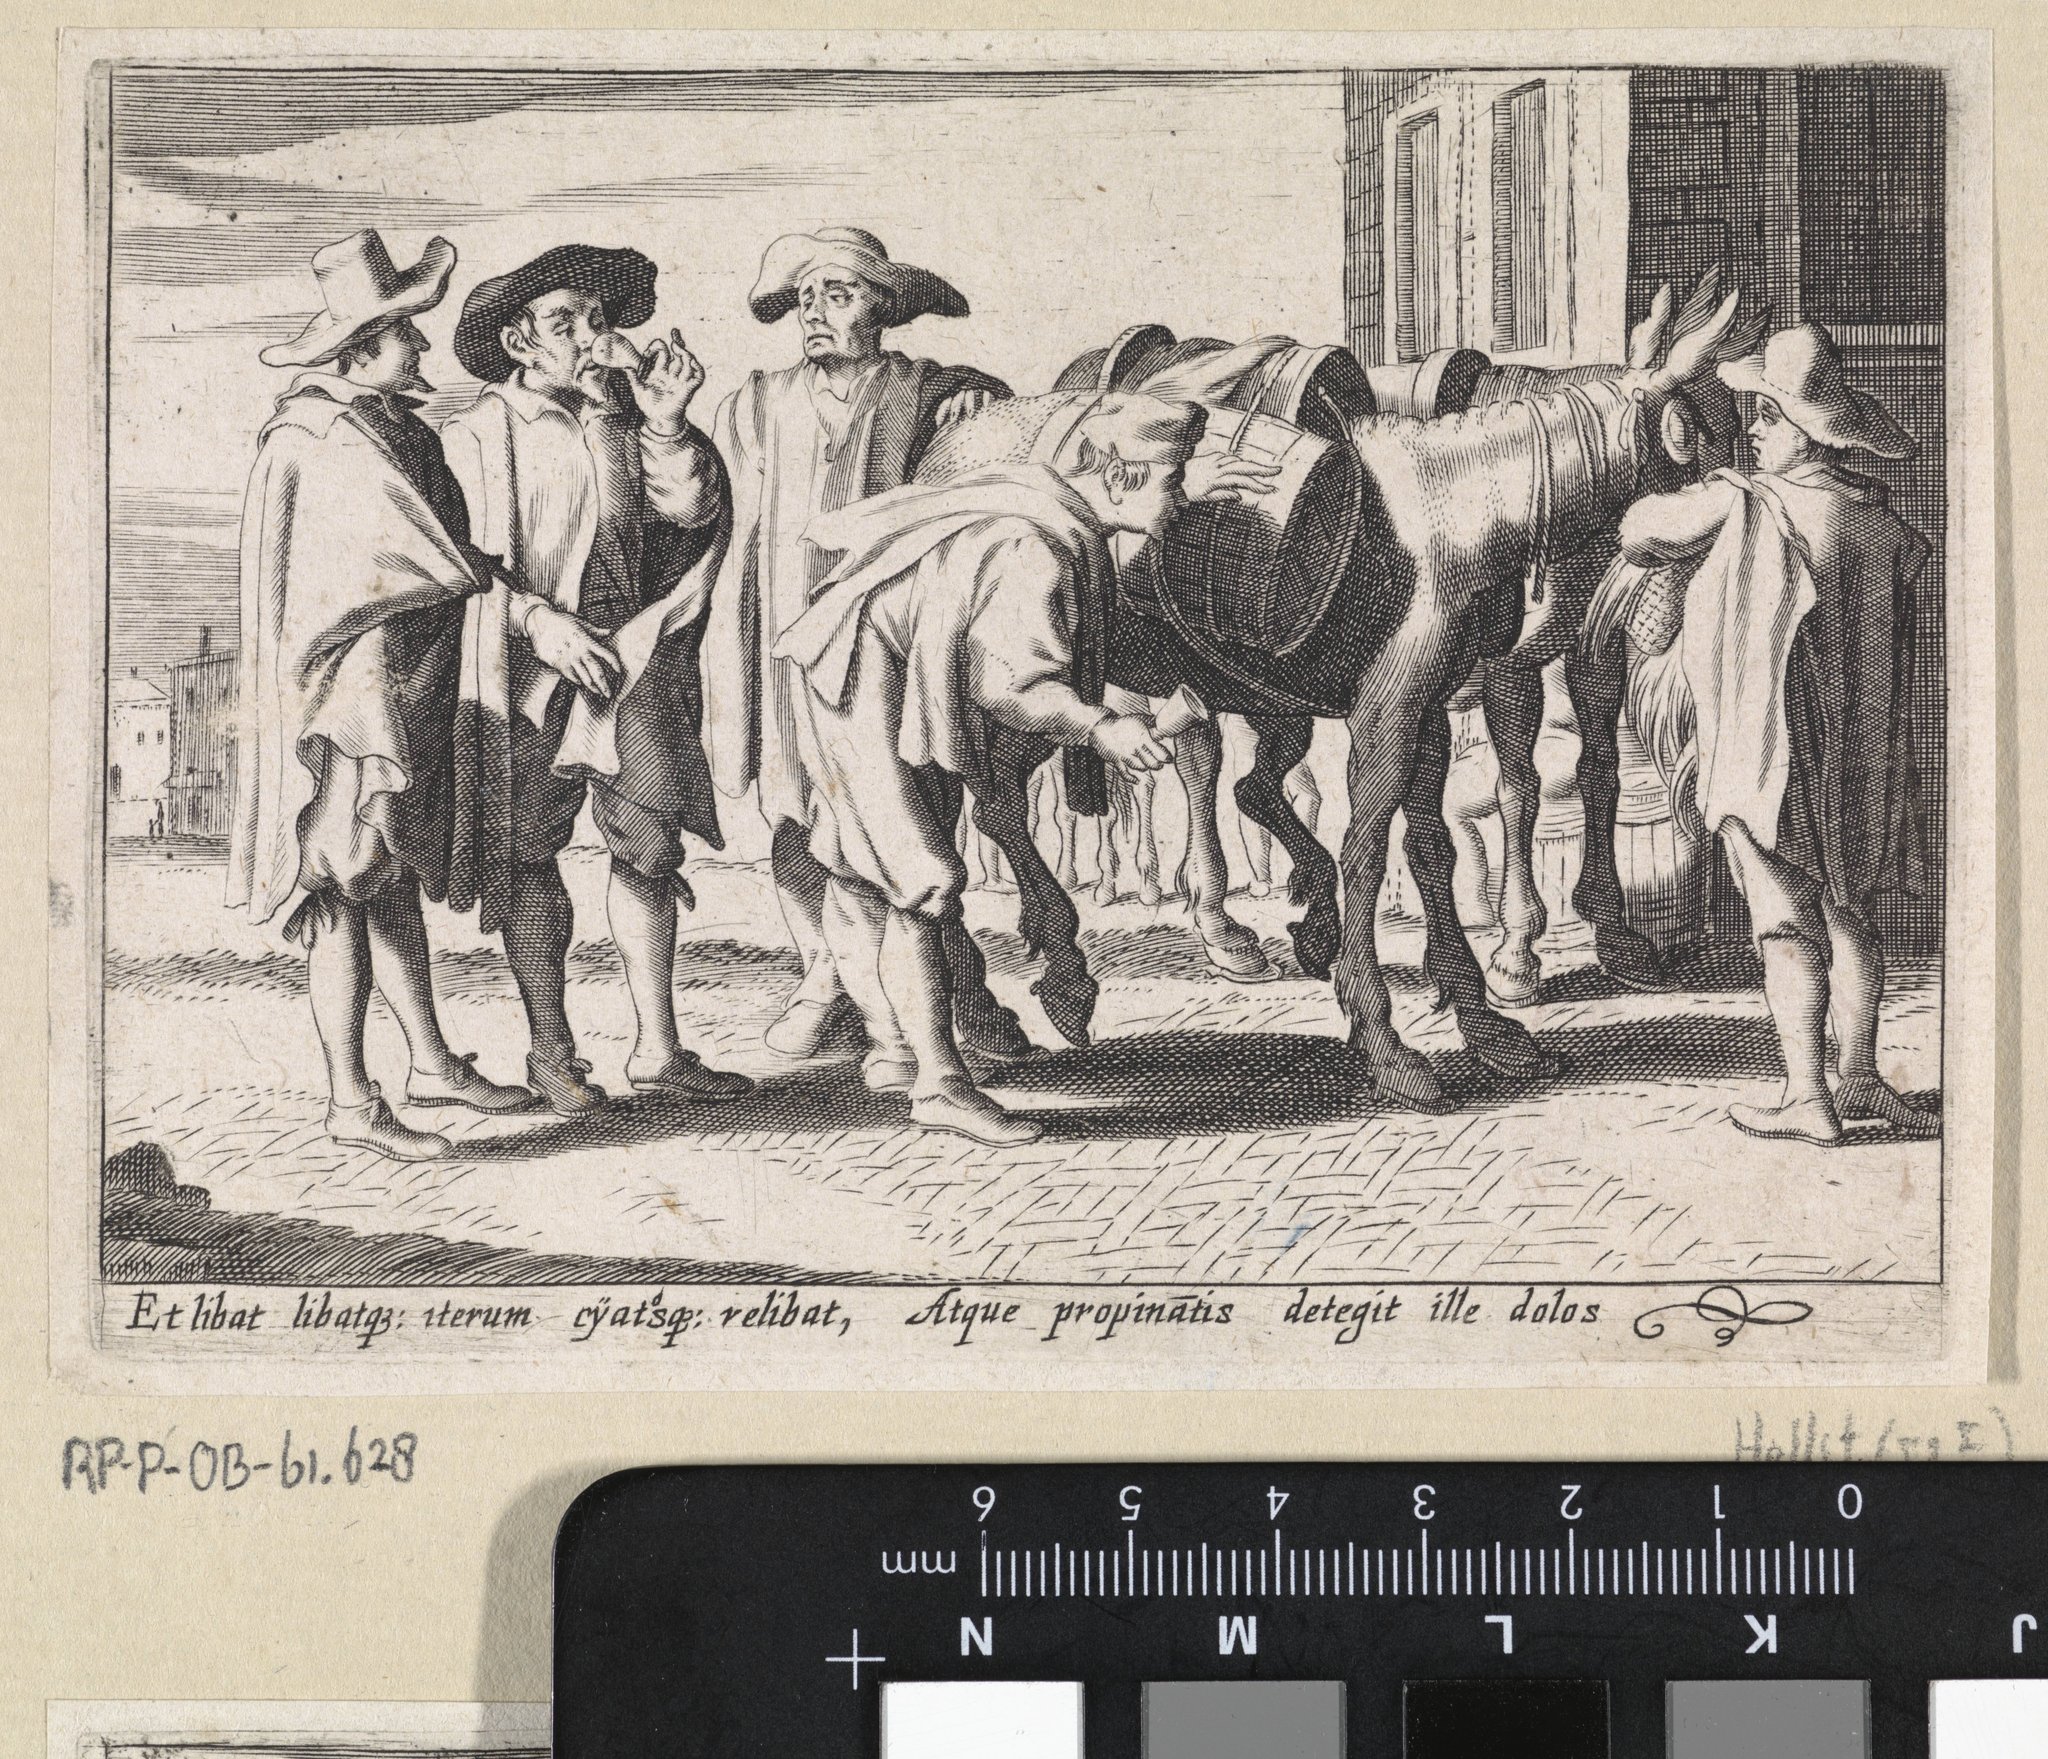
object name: print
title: Wijnhandelaren bij een ezel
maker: Anonymous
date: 1613-1667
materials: paper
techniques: engraving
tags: ass, donkey, selling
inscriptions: collector's mark: Lugt 240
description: Een man tapt wijn uit een vat dat op de rug van een ezel gebonden is. Een andere man nipt reeds uit zijn glas. In de marge een onderschrift in het Latijn.